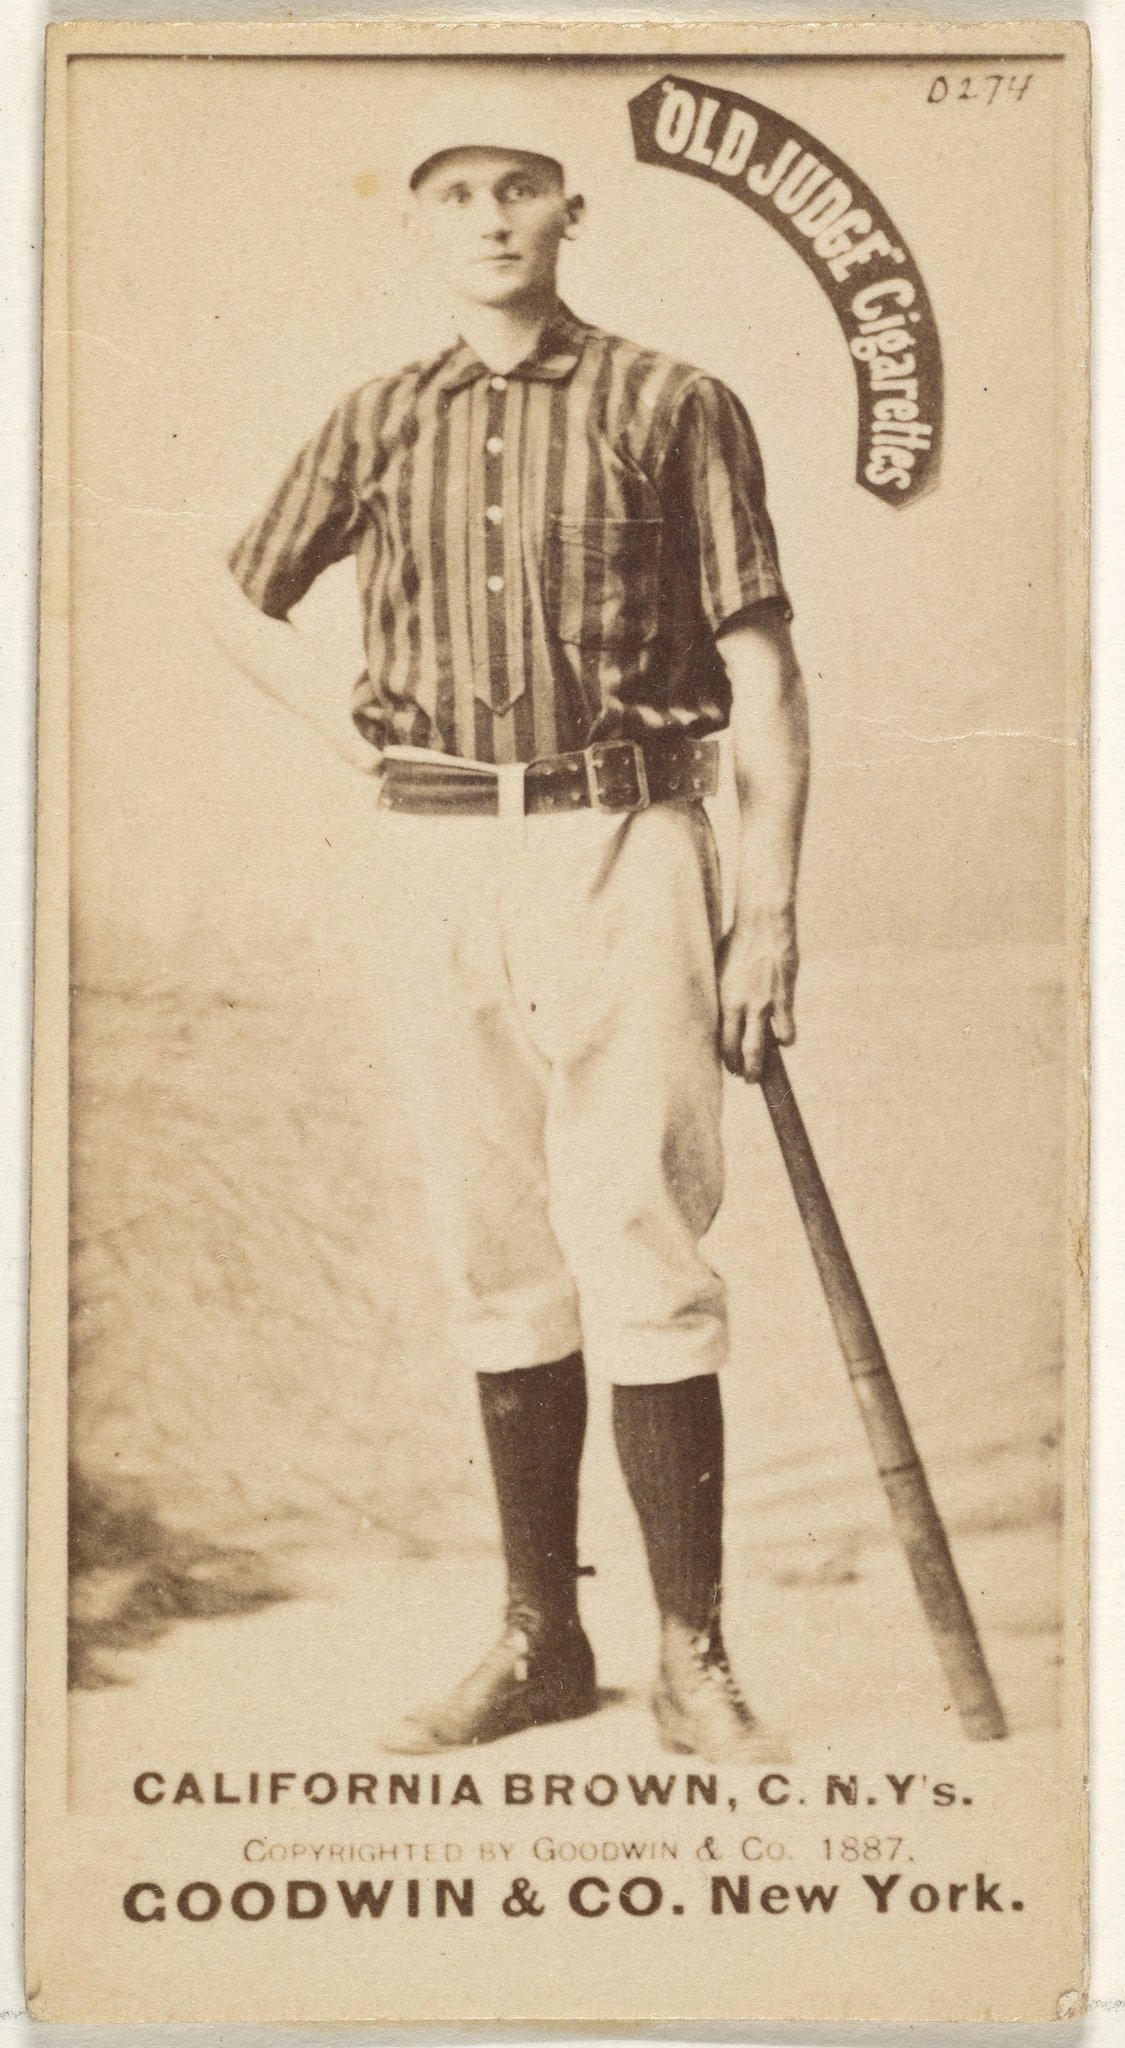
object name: baseball card, photograph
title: William "California" Brown, Catcher, New York, from the Old Judge series (N172) for Old Judge Cigarettes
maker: goodwin & company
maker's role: publisher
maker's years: 1850-1950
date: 1887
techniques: albumen silver print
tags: men,portraits,baseball,athletes